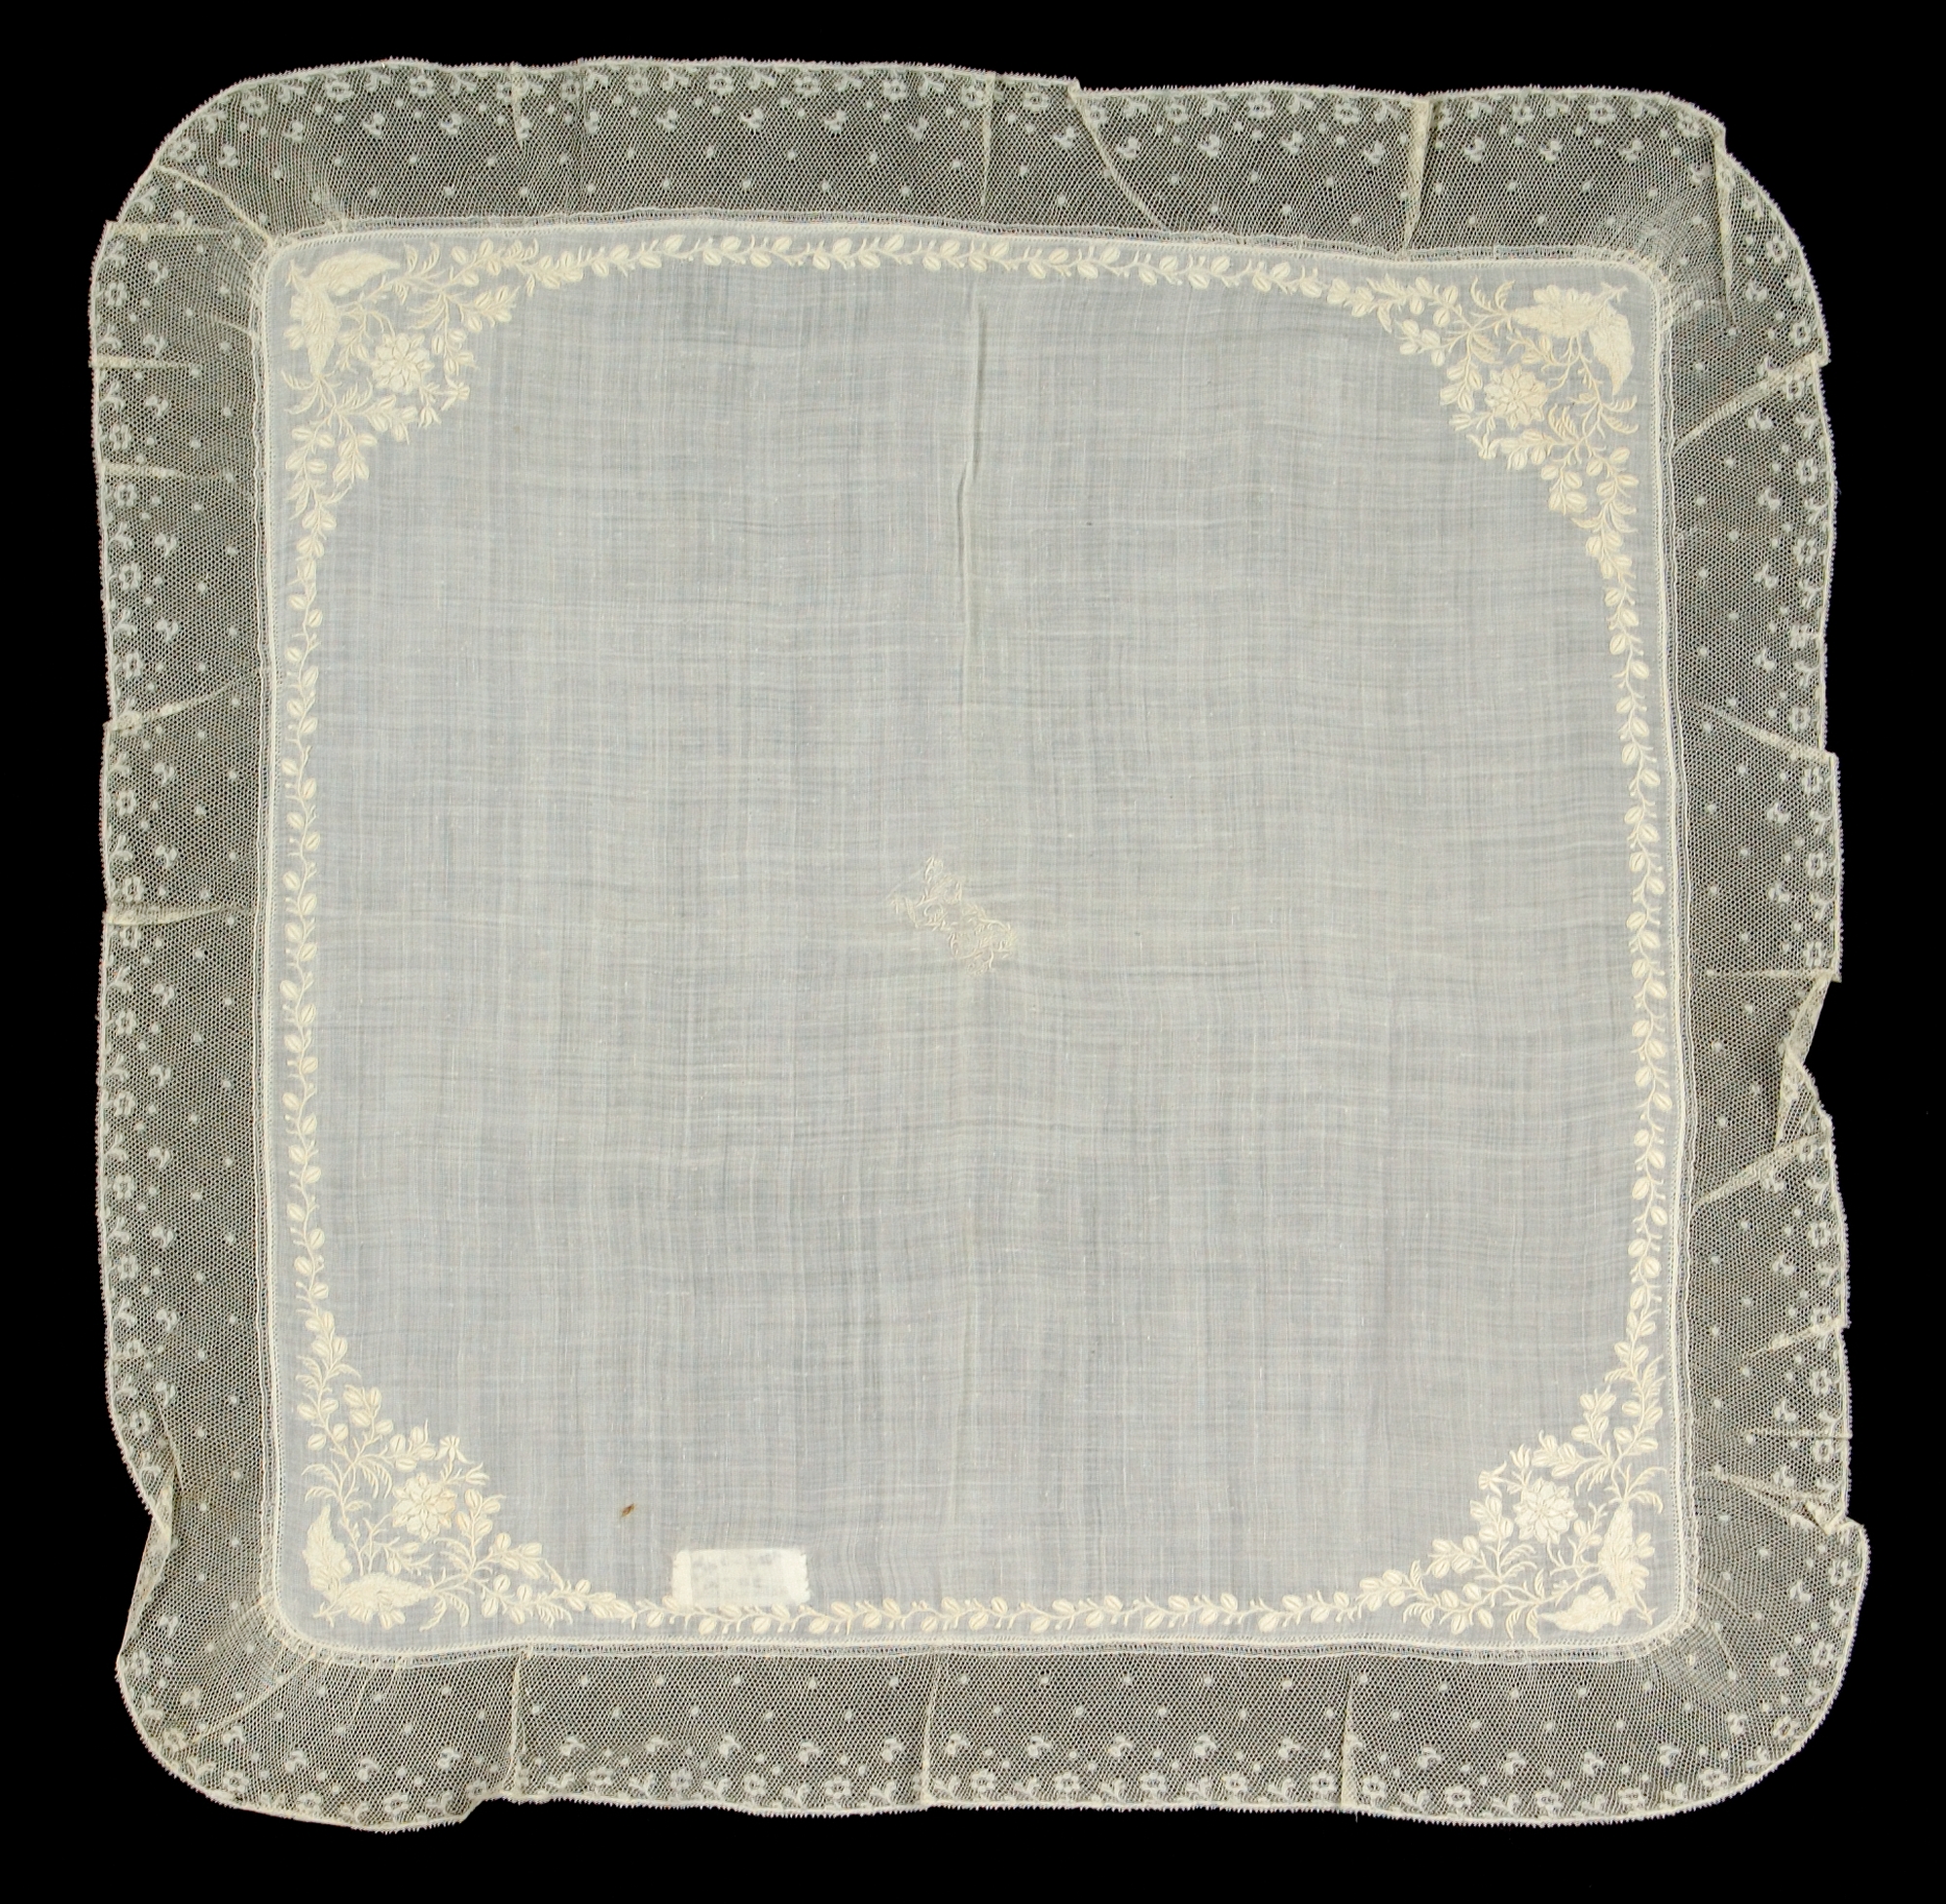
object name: handkerchief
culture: french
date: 1825-1850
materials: linen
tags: flowers